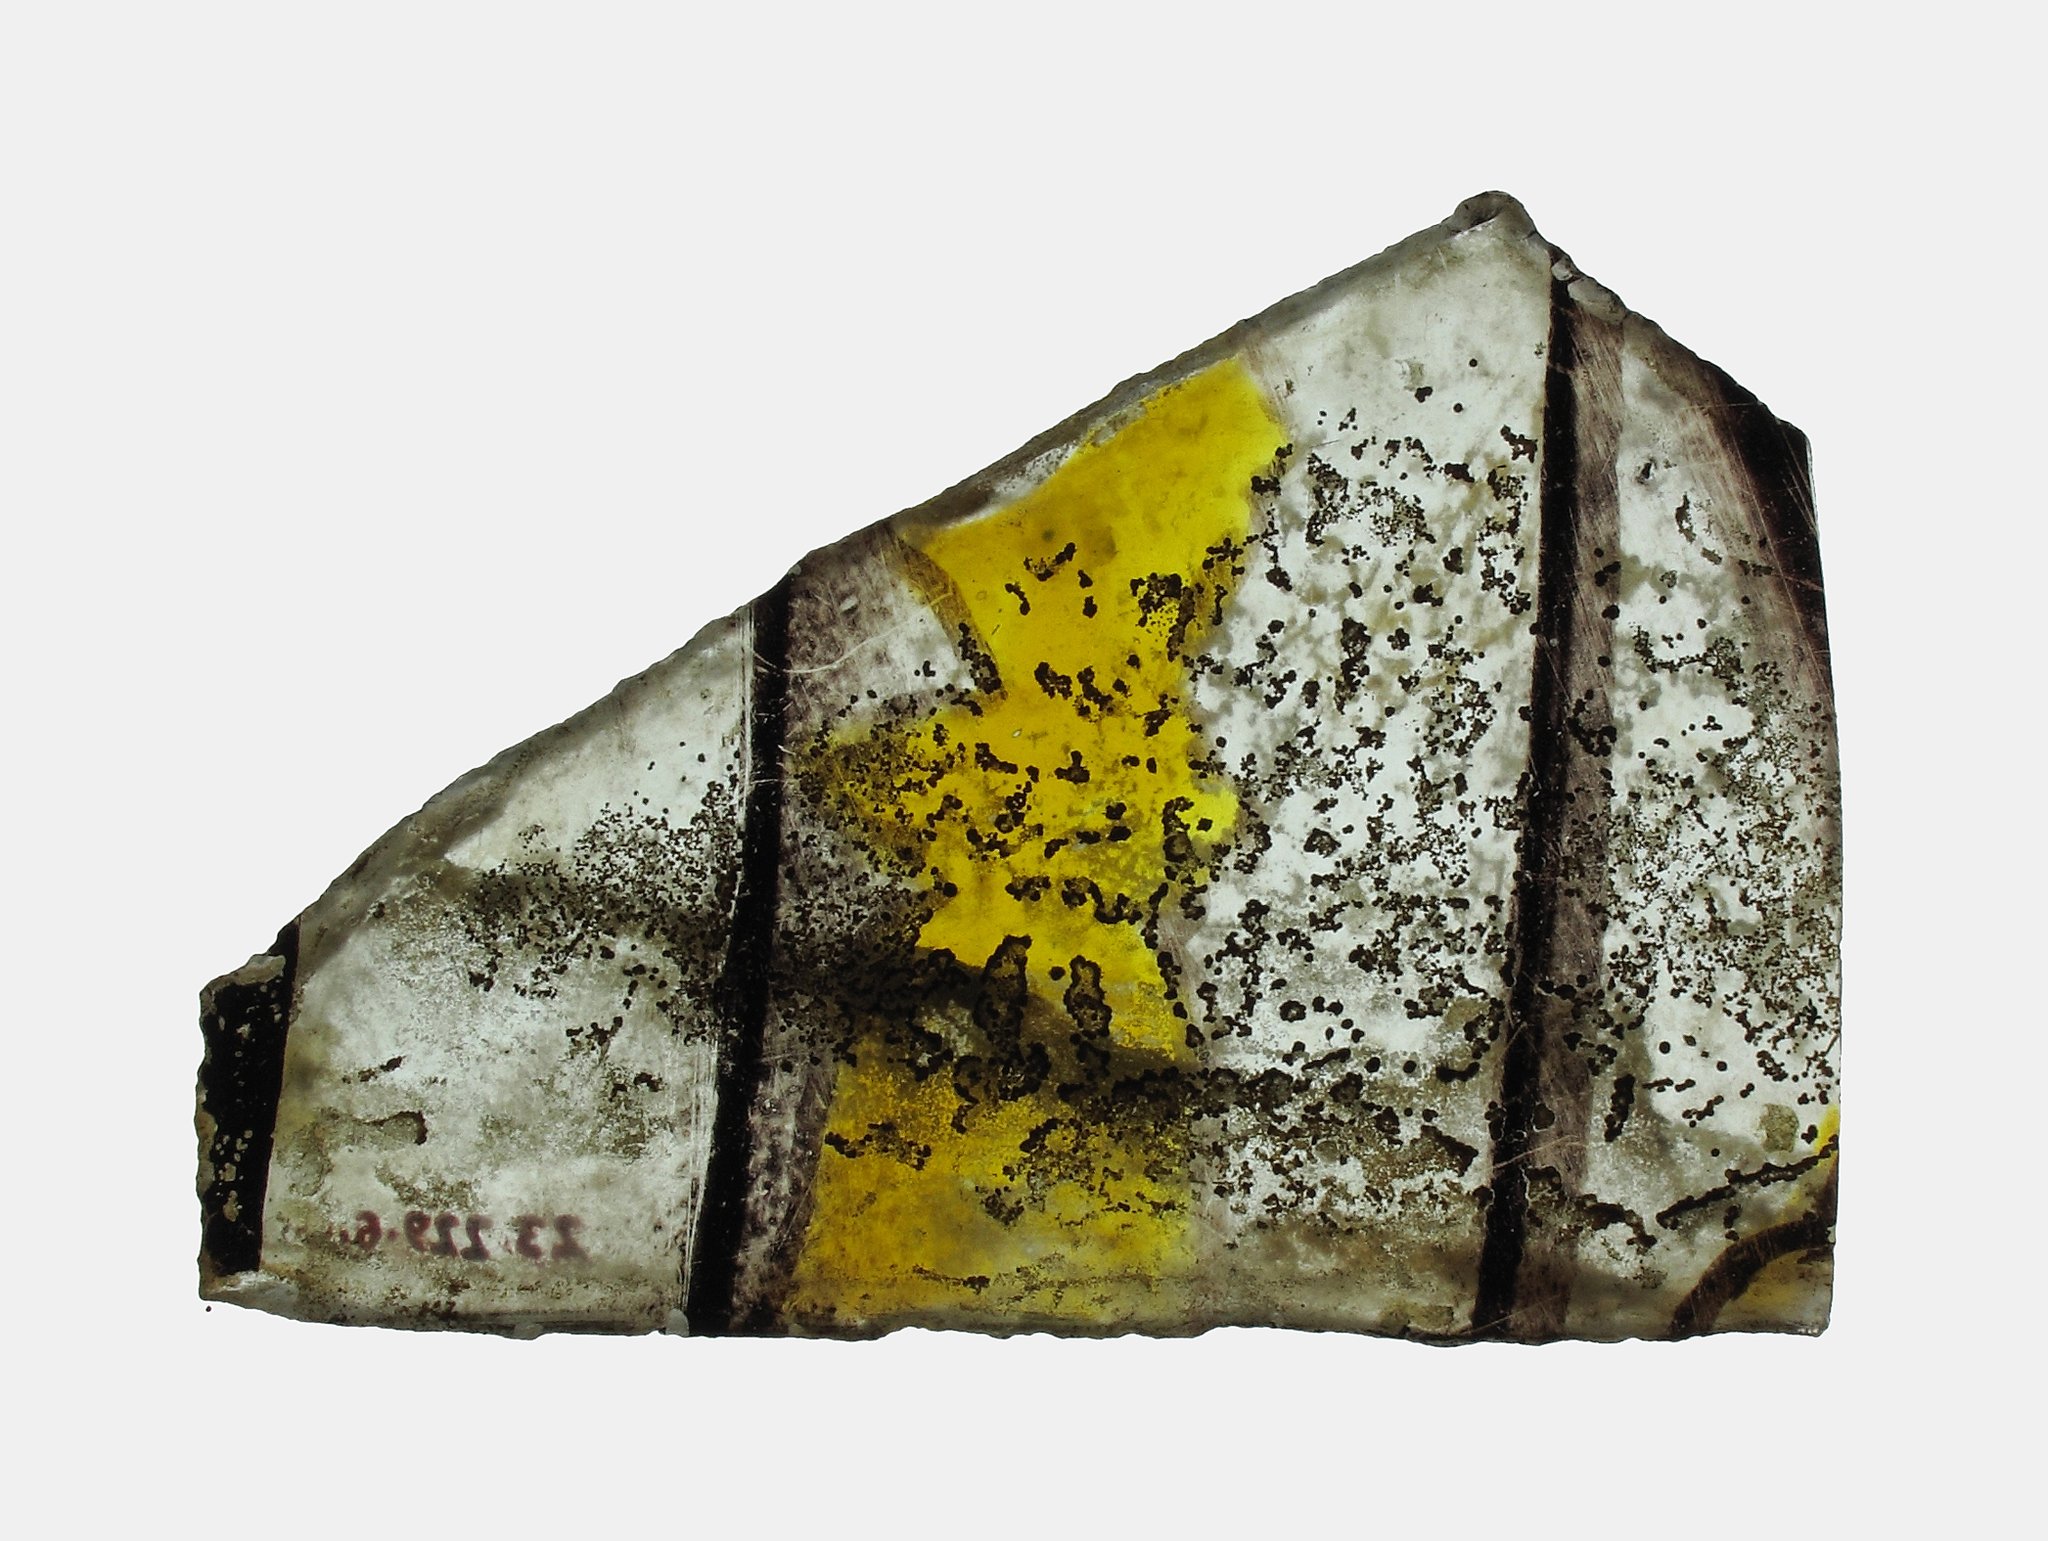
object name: fragment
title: Glass Fragment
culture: french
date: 1401-1500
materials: glass